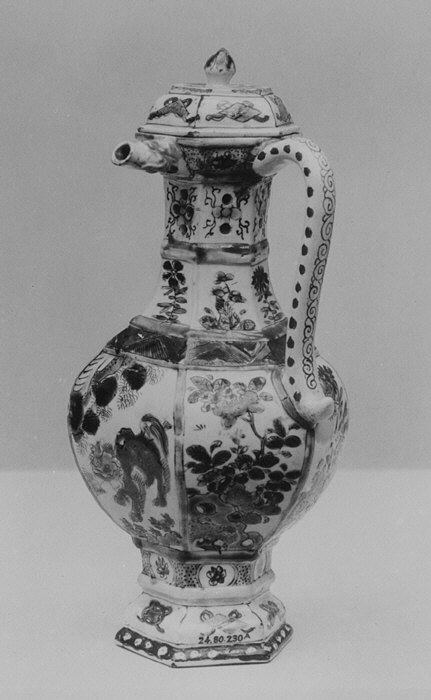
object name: ewer with cover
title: Ewer with cover (one of a pair)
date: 1715-1730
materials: hard paste porcelain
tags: flowers